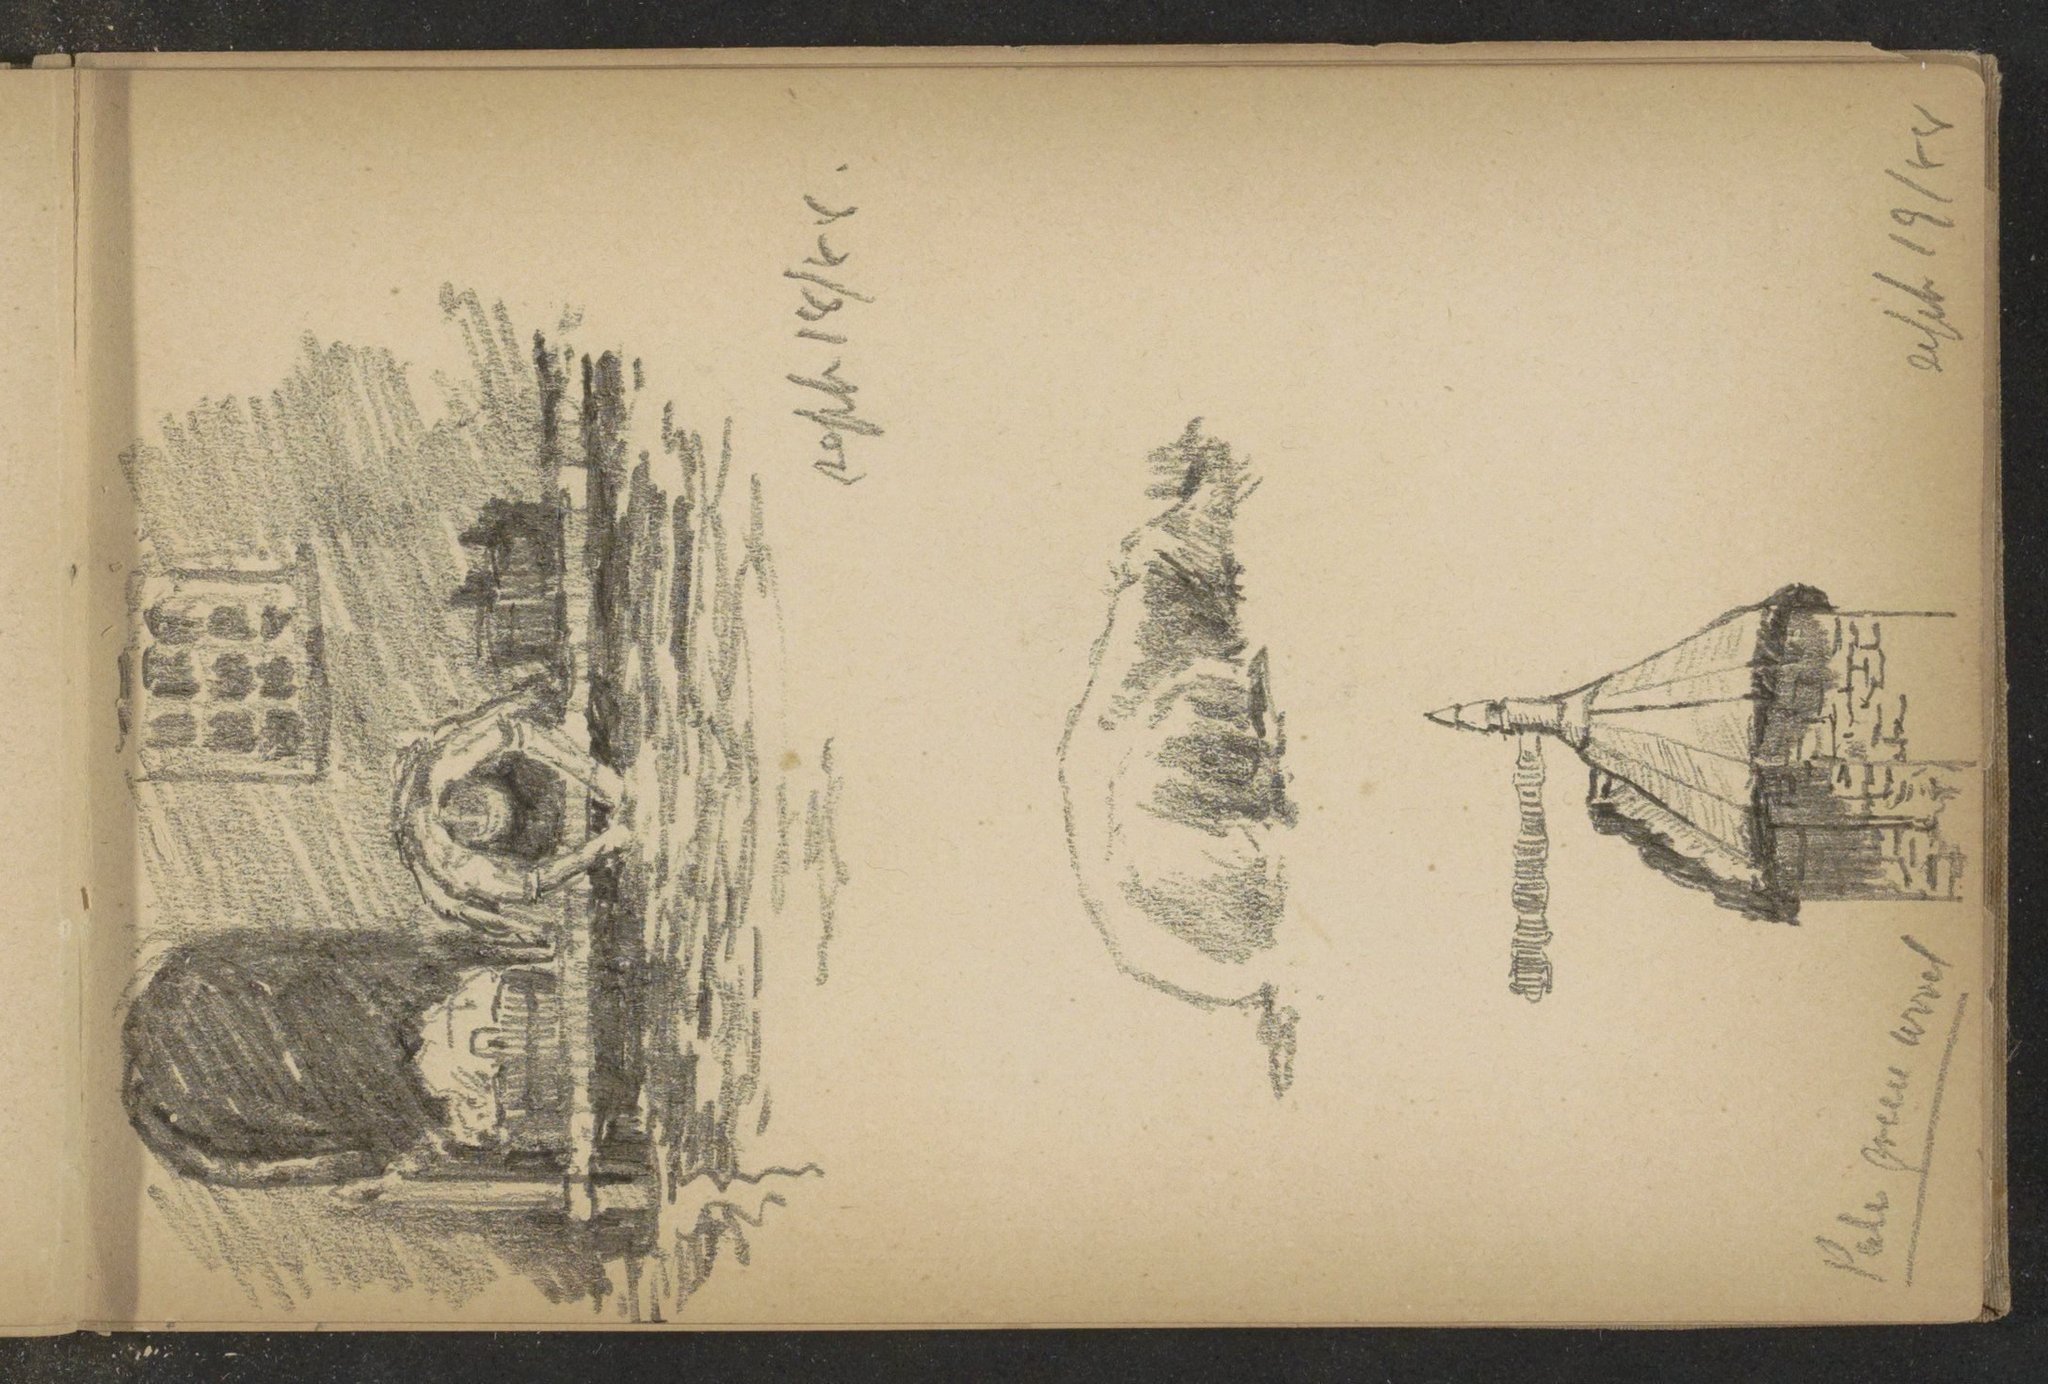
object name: sketchbook leaf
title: Wasvrouw aan een kade, een liggend dier en een toren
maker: alexander shilling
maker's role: draughtsman, print maker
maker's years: 1859-1937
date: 1809-1888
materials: paper, pencil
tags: animals, laundering, tower (of house or building)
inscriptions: date and inscription: ‘sept 18/88/ pale green wood/ sept 19/88’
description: De vrouw zit op haar knieën aan een gracht en houdt een stuk wasgoed in het water. Naast haar staan twee houten tonnen op de kade. Blad 27 recto uit een schetsboek met 34 bladen.